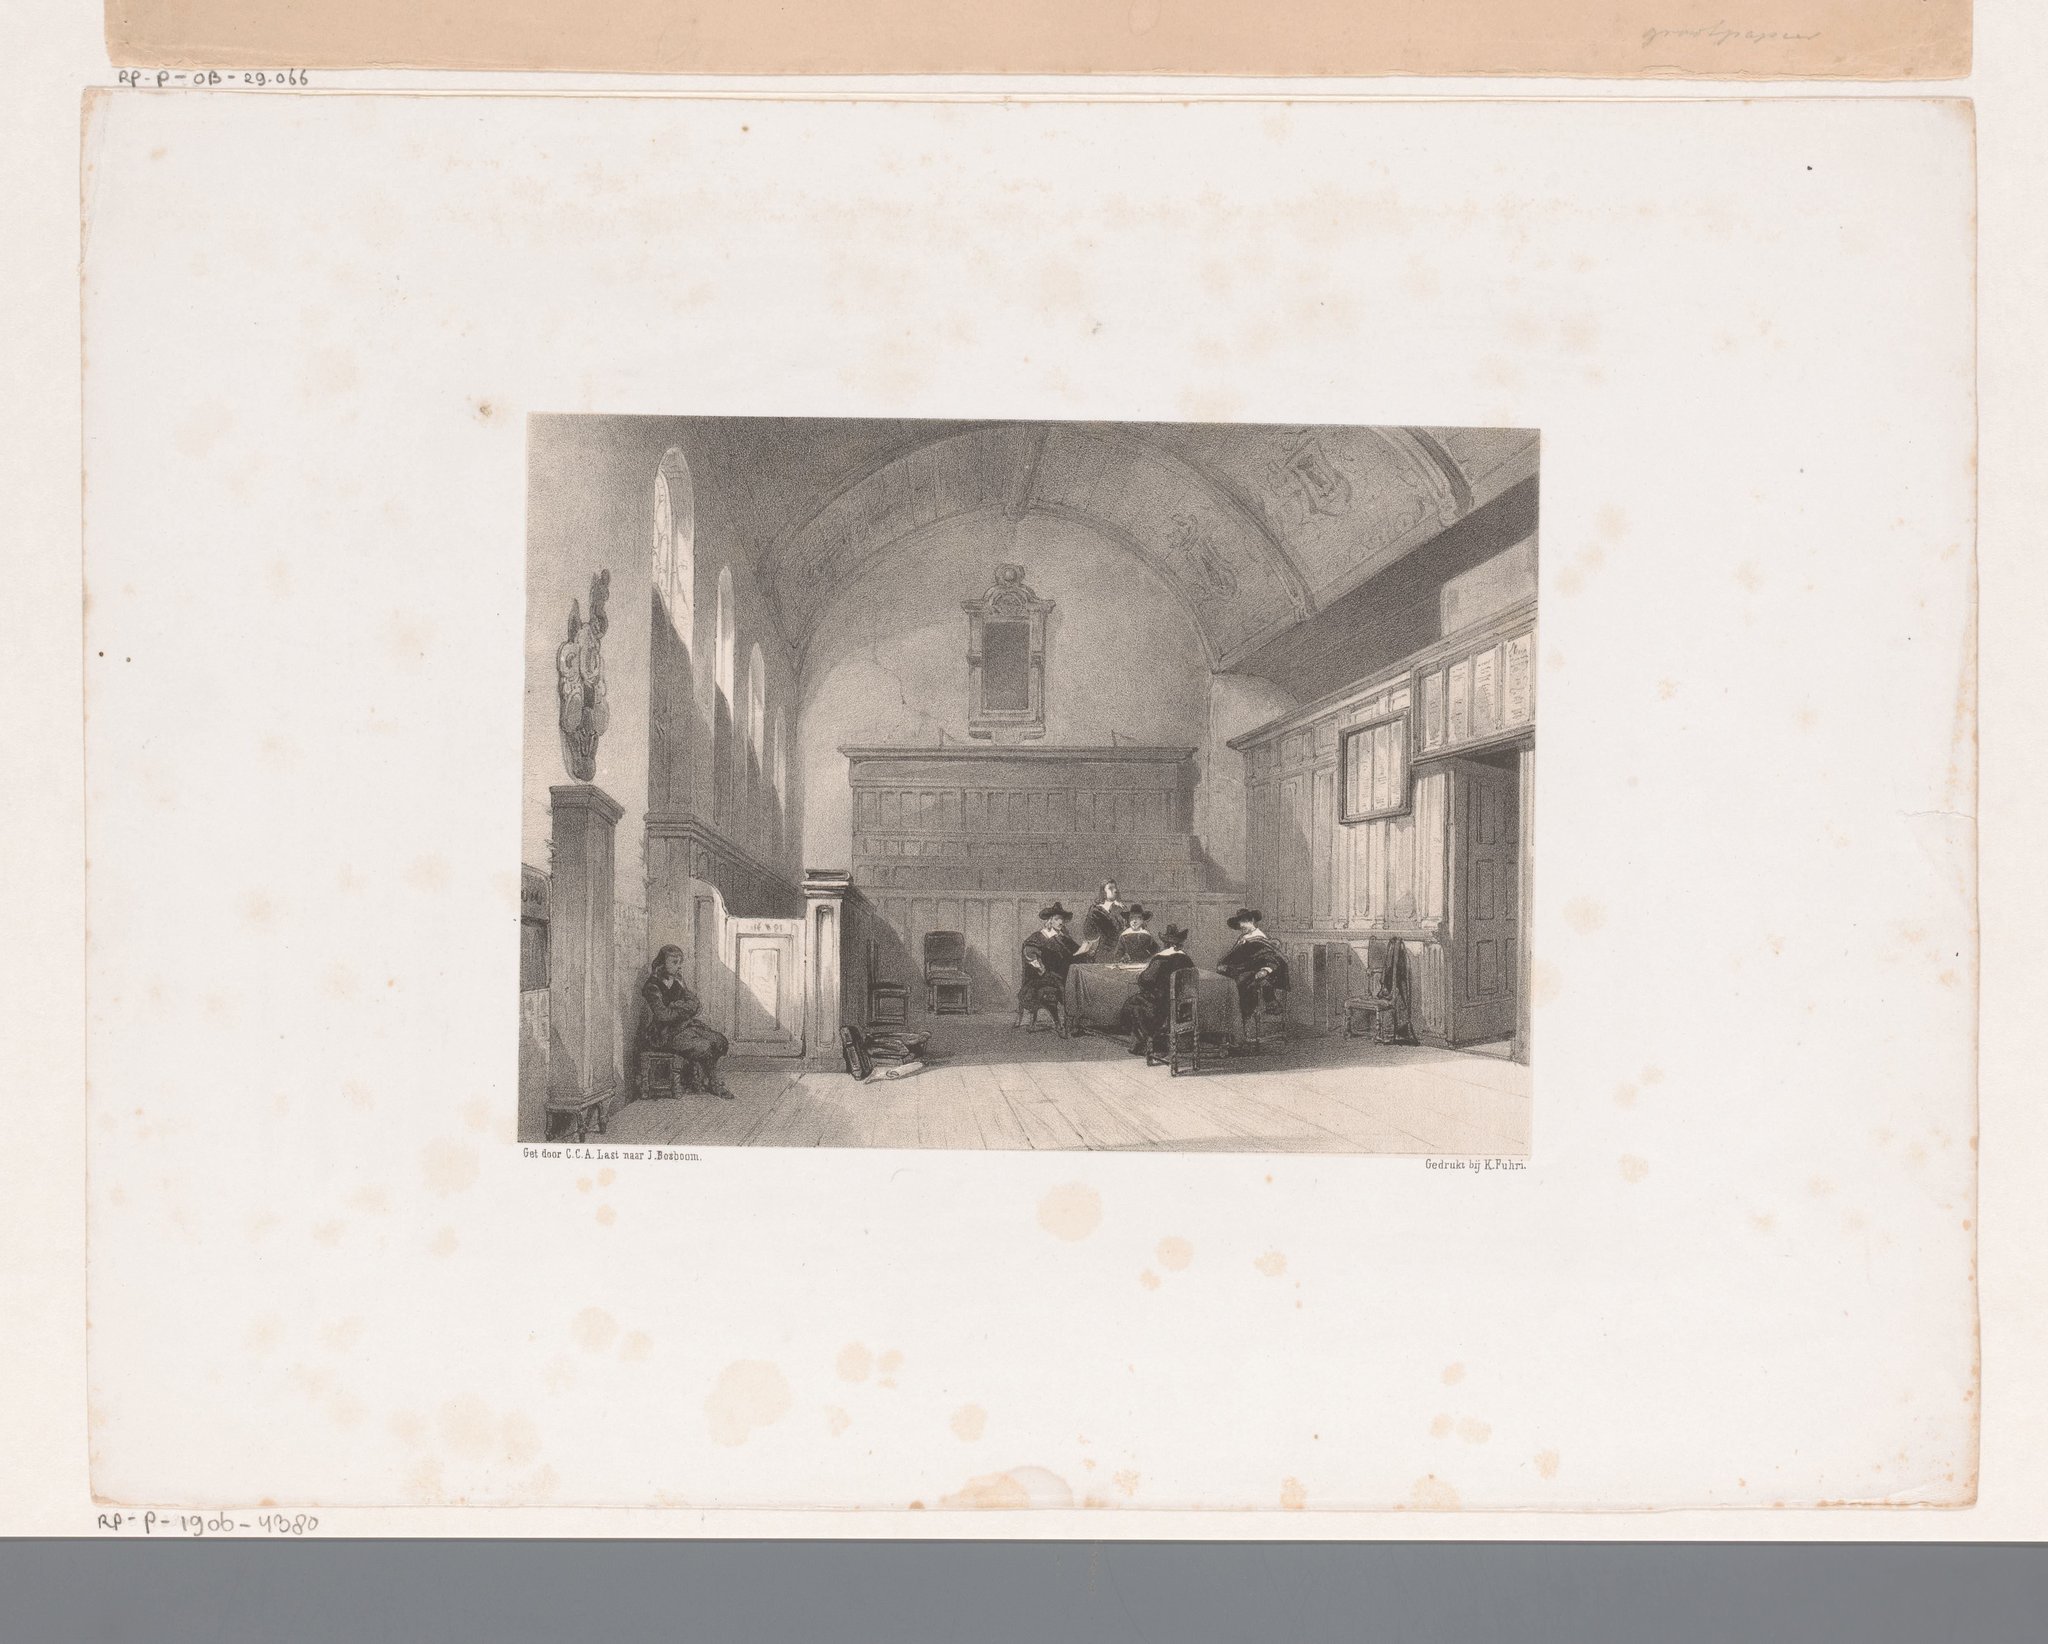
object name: print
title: Kerkeraadskamer te Alkmaar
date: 1844-1855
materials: paper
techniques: tone lithography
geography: the hague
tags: meeting, assembly, assembly-room, parts of church interior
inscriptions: collector's mark: Lugt 2228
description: Het kerkbestuur zit met elkaar om een tafel. Links zit een man tegen de muur.